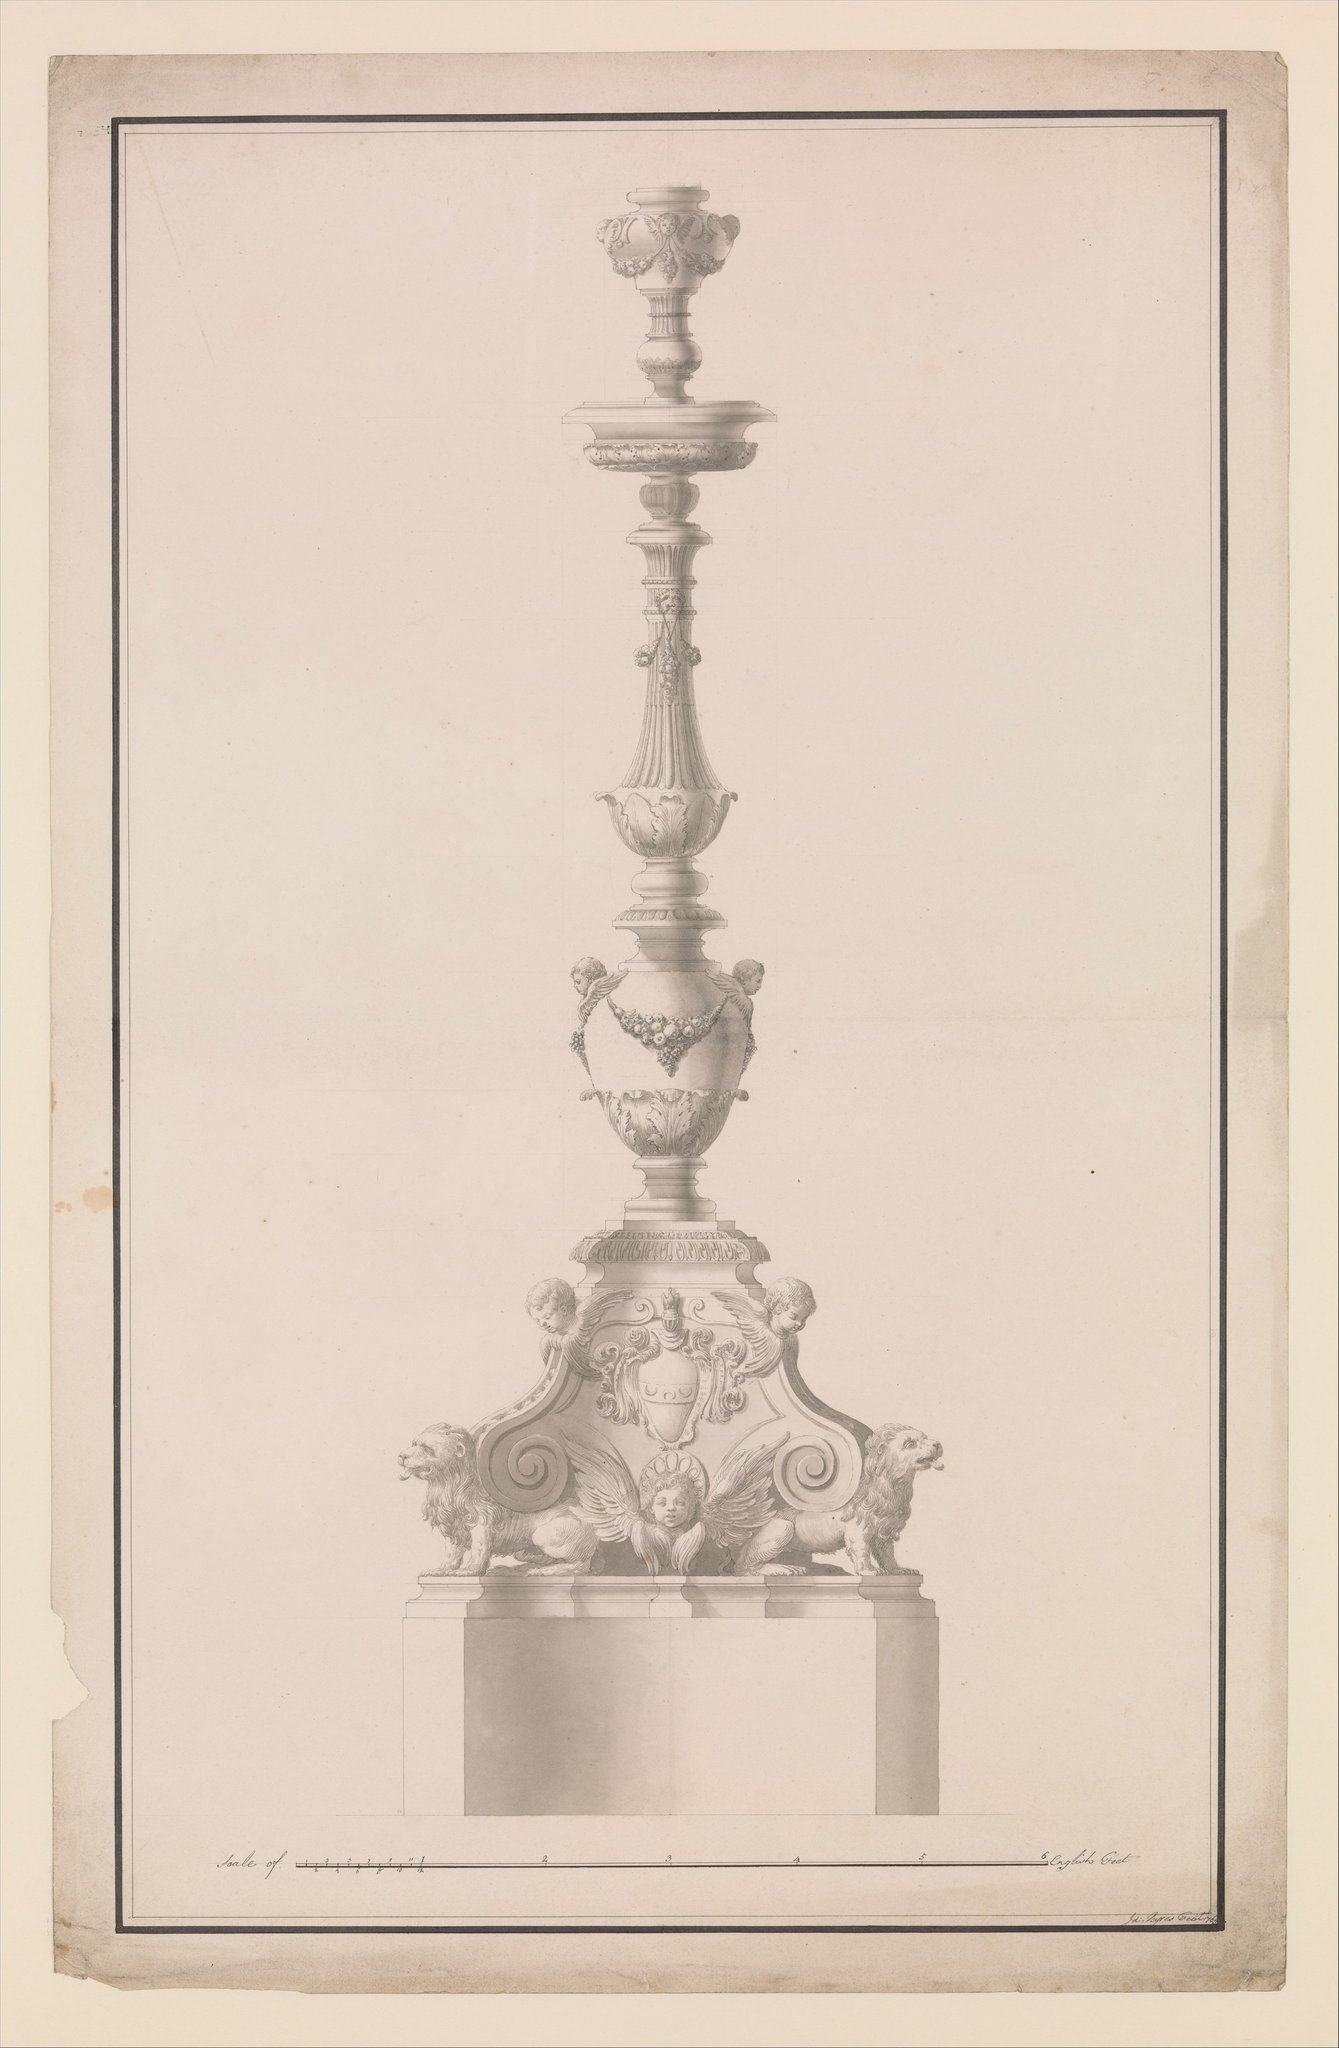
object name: drawing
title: Design for a Monumental Candelabrum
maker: james byres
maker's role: designer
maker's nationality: british, scottish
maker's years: 1733-1817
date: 1765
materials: ink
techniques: brush, pen, wash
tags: candelabra